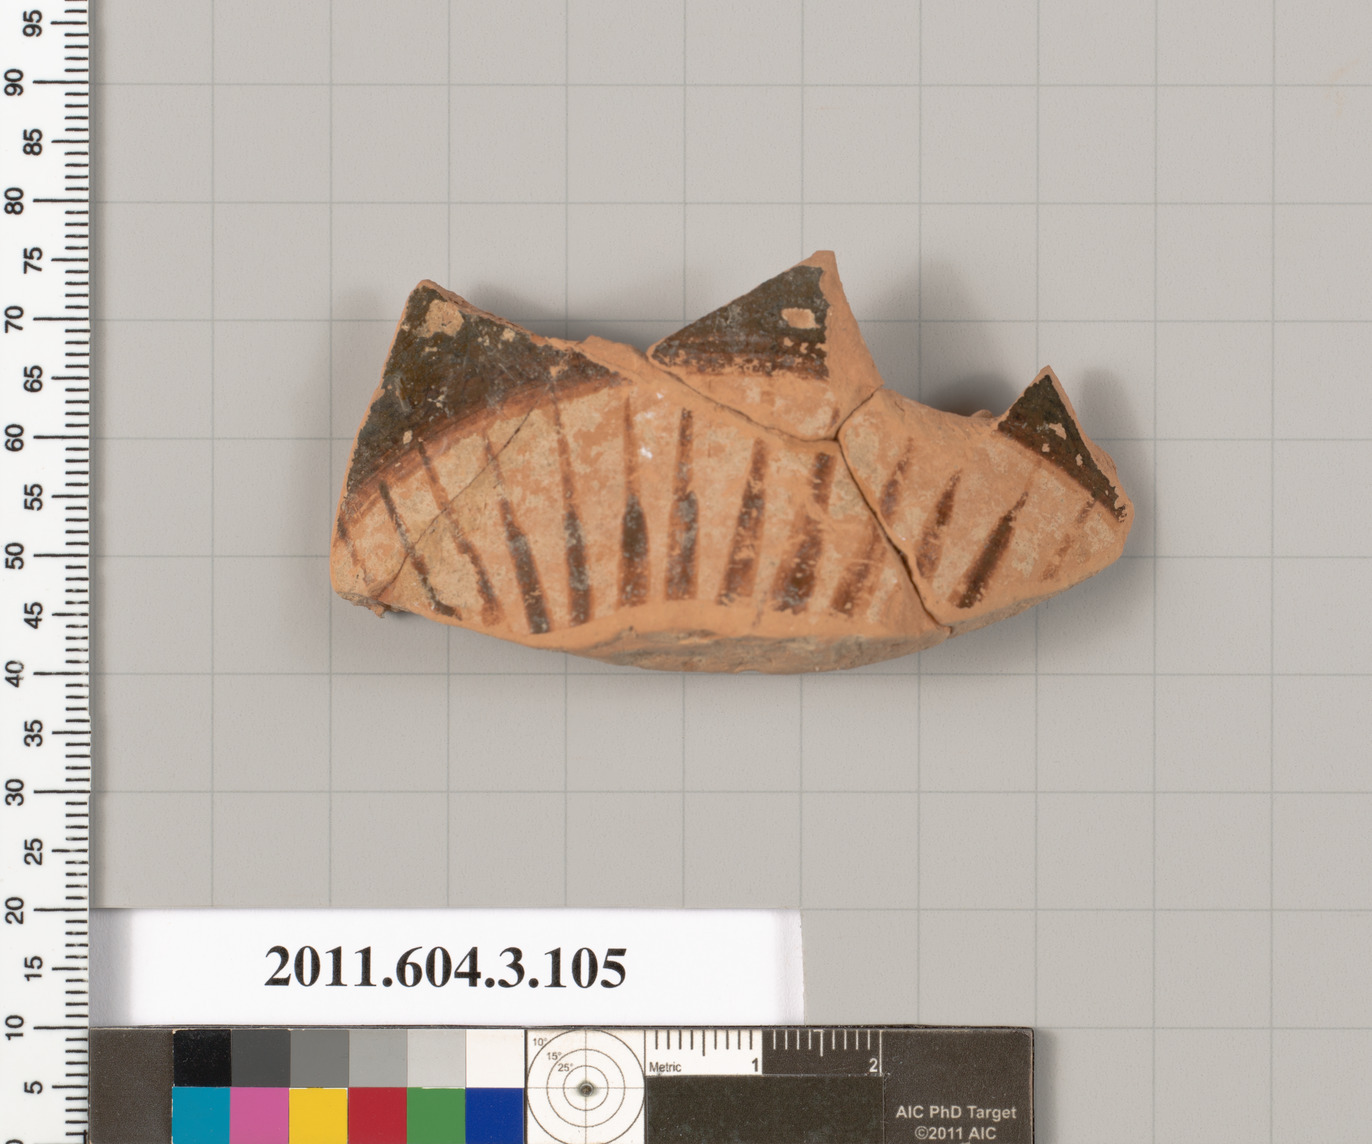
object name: amphora fragment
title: Terracotta fragment of an amphora (jar)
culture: greek, attic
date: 600-468 BCE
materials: terracotta